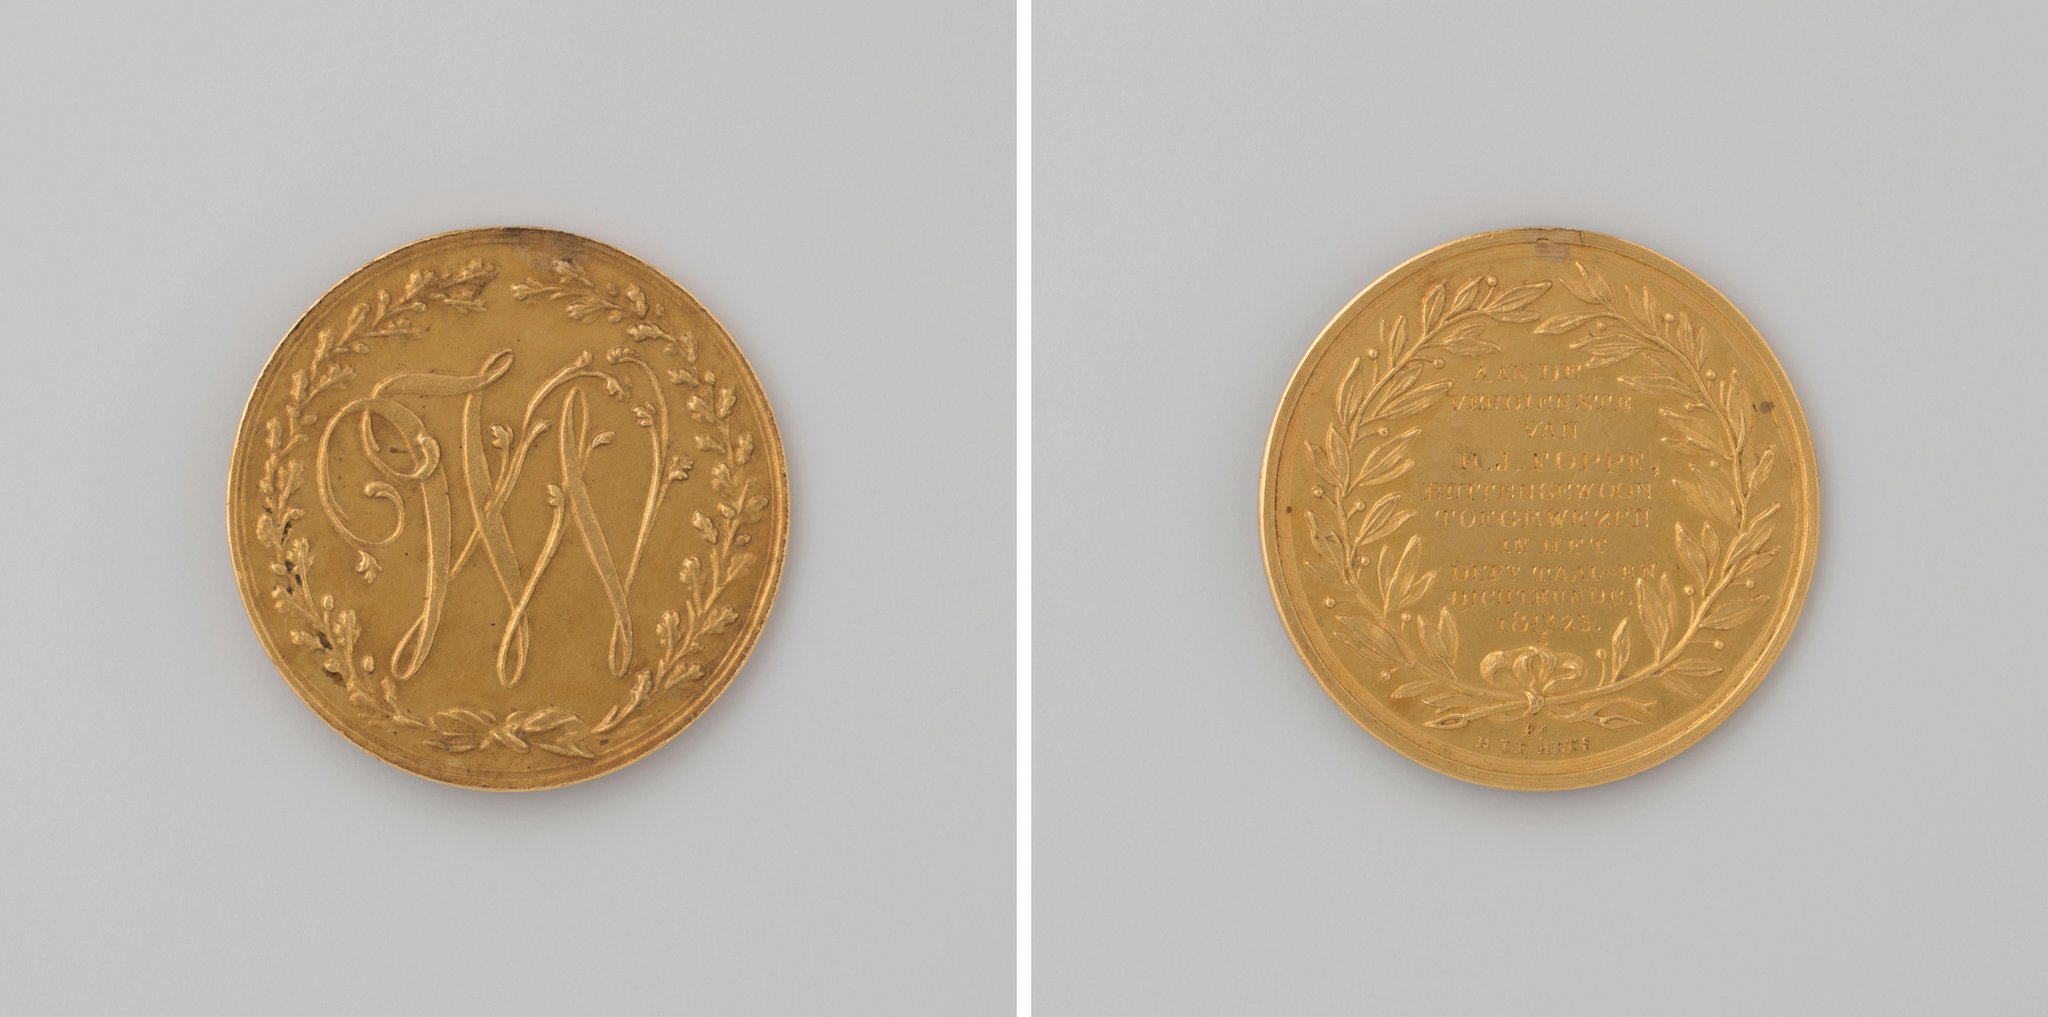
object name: medal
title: Letterkundig Gezelschap V.W. te Amsterdam, penning toegekend aan H.J. Foppe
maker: hendrik de heus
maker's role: medailleur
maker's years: -1838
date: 1825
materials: gold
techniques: striking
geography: netherlands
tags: amsterdam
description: Gouden penning. Voorzijde: letters V en W in krans van eikeloof. Keerzijde: opschrift binnen lauwerkrans.